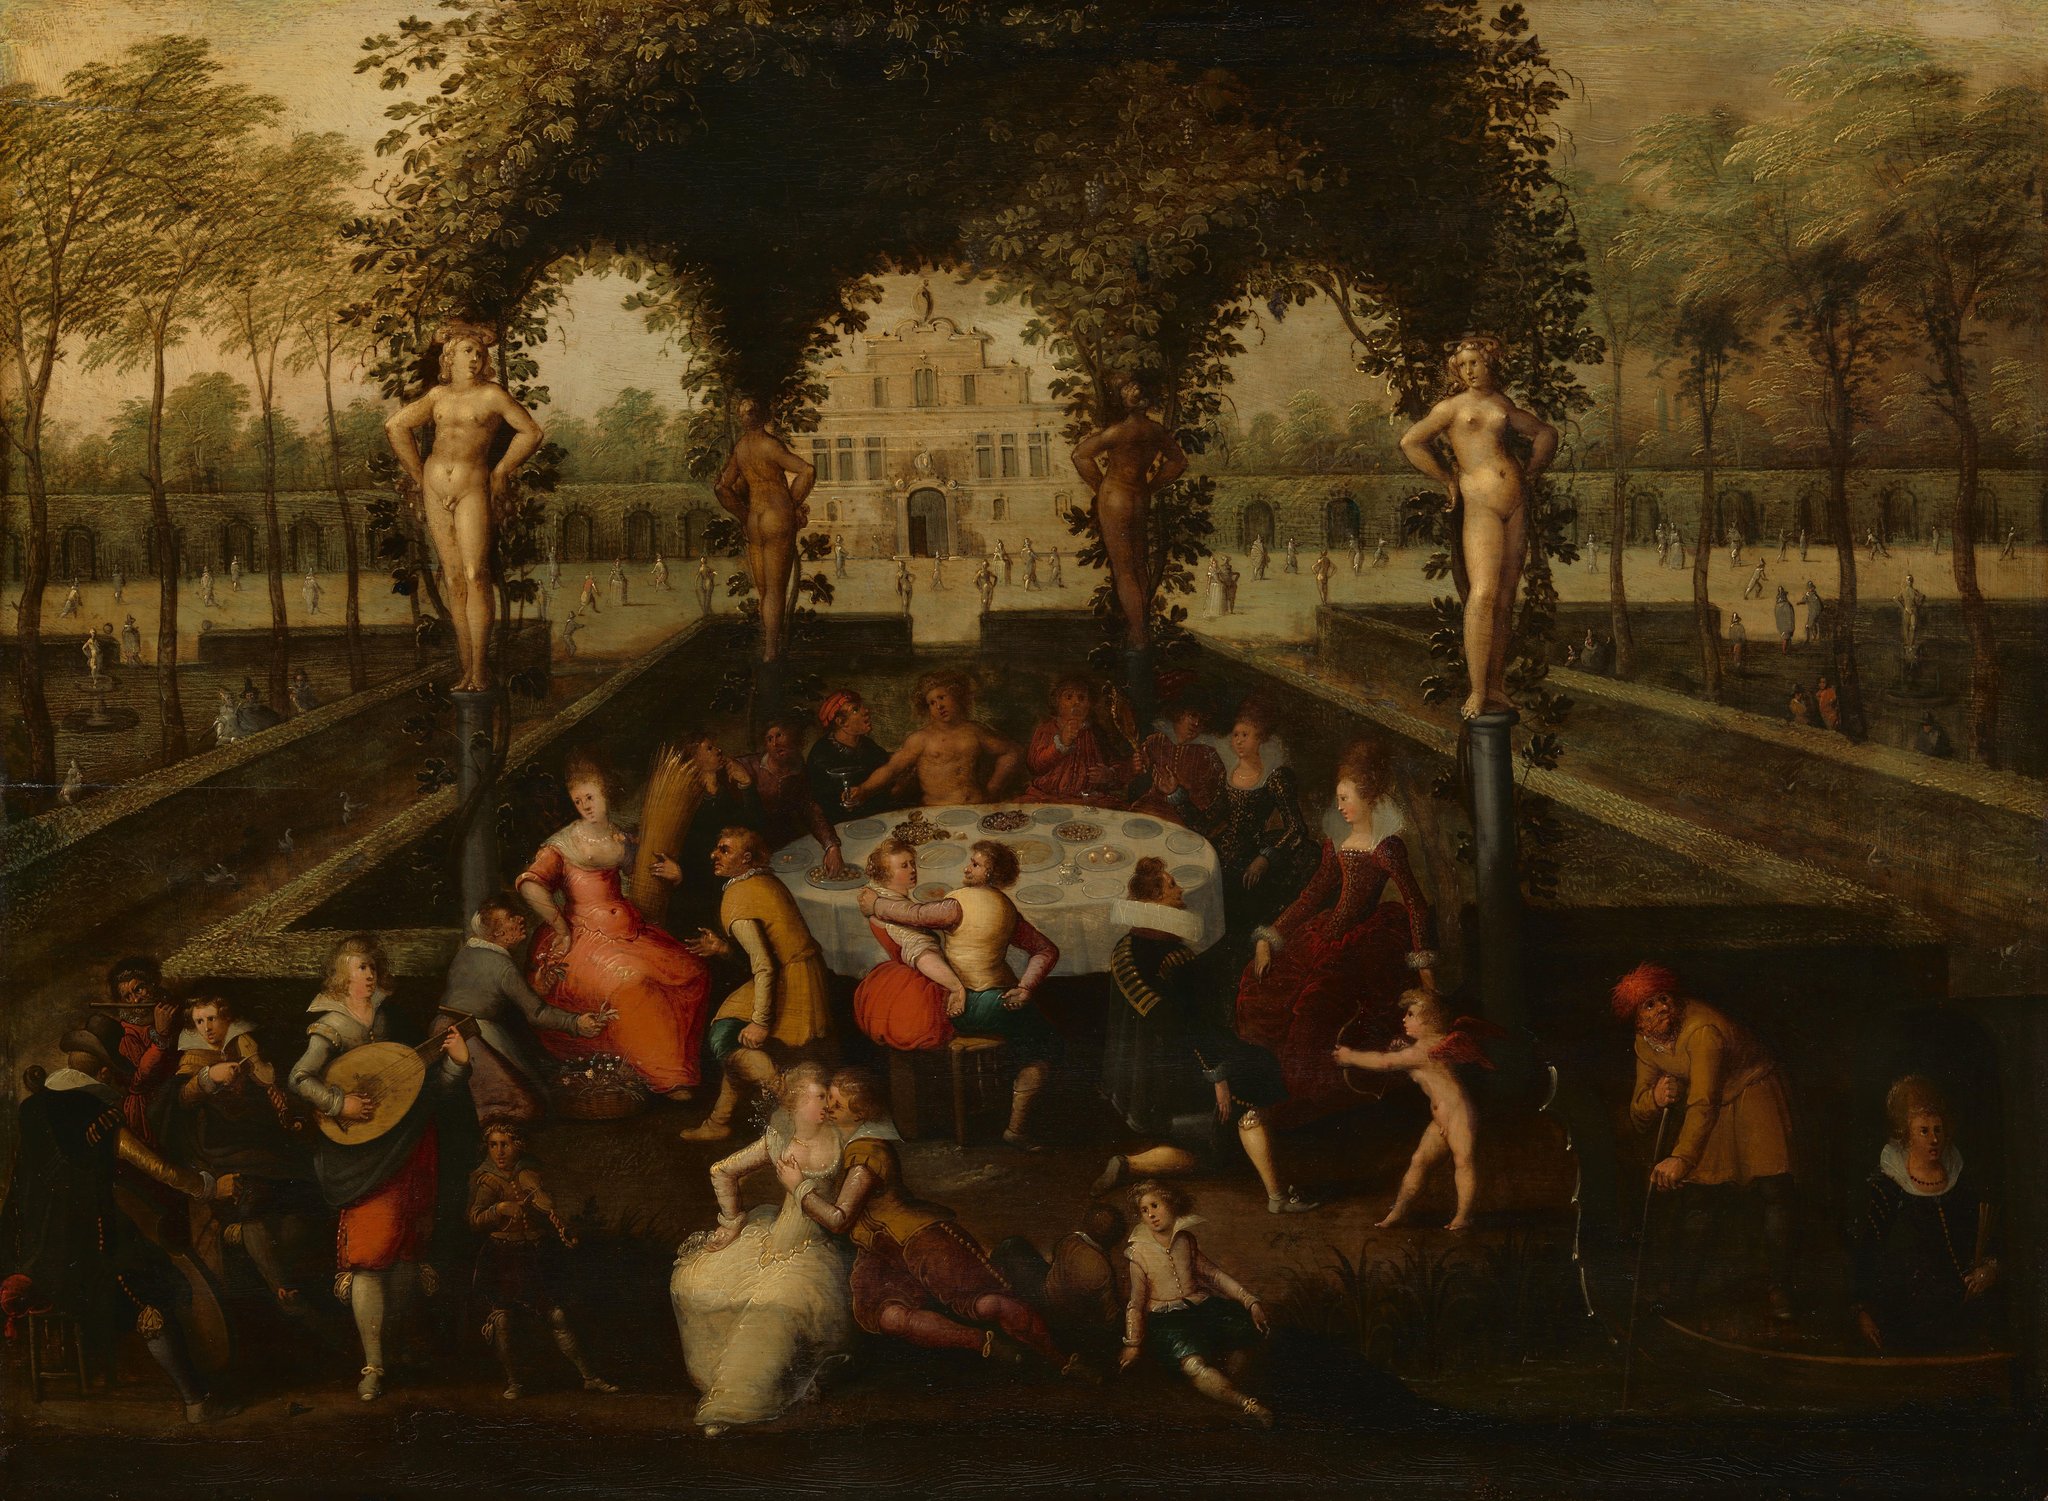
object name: painting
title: Venus, Bacchus and Ceres with Mortals in a Garden of Love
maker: louis de caullery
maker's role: painter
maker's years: 1579-1621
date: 1590-1621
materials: oil, panel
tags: garden of love, court of love, 'fête galante', 'sine cerere et baccho friget venus', lovers; courting, flirting, banquet of elegant company - cc - out of doors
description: Minnetuin of Liefdestuin waarin Venus, Bacchus en Ceres met liefdesparen rond een tafel onder een prieel zitten. Op de voorgrond een vrijend paar en links een groep muzikanten (luit, viool, cello en fluit). Rechts komt een dame in een boot aangevaren.